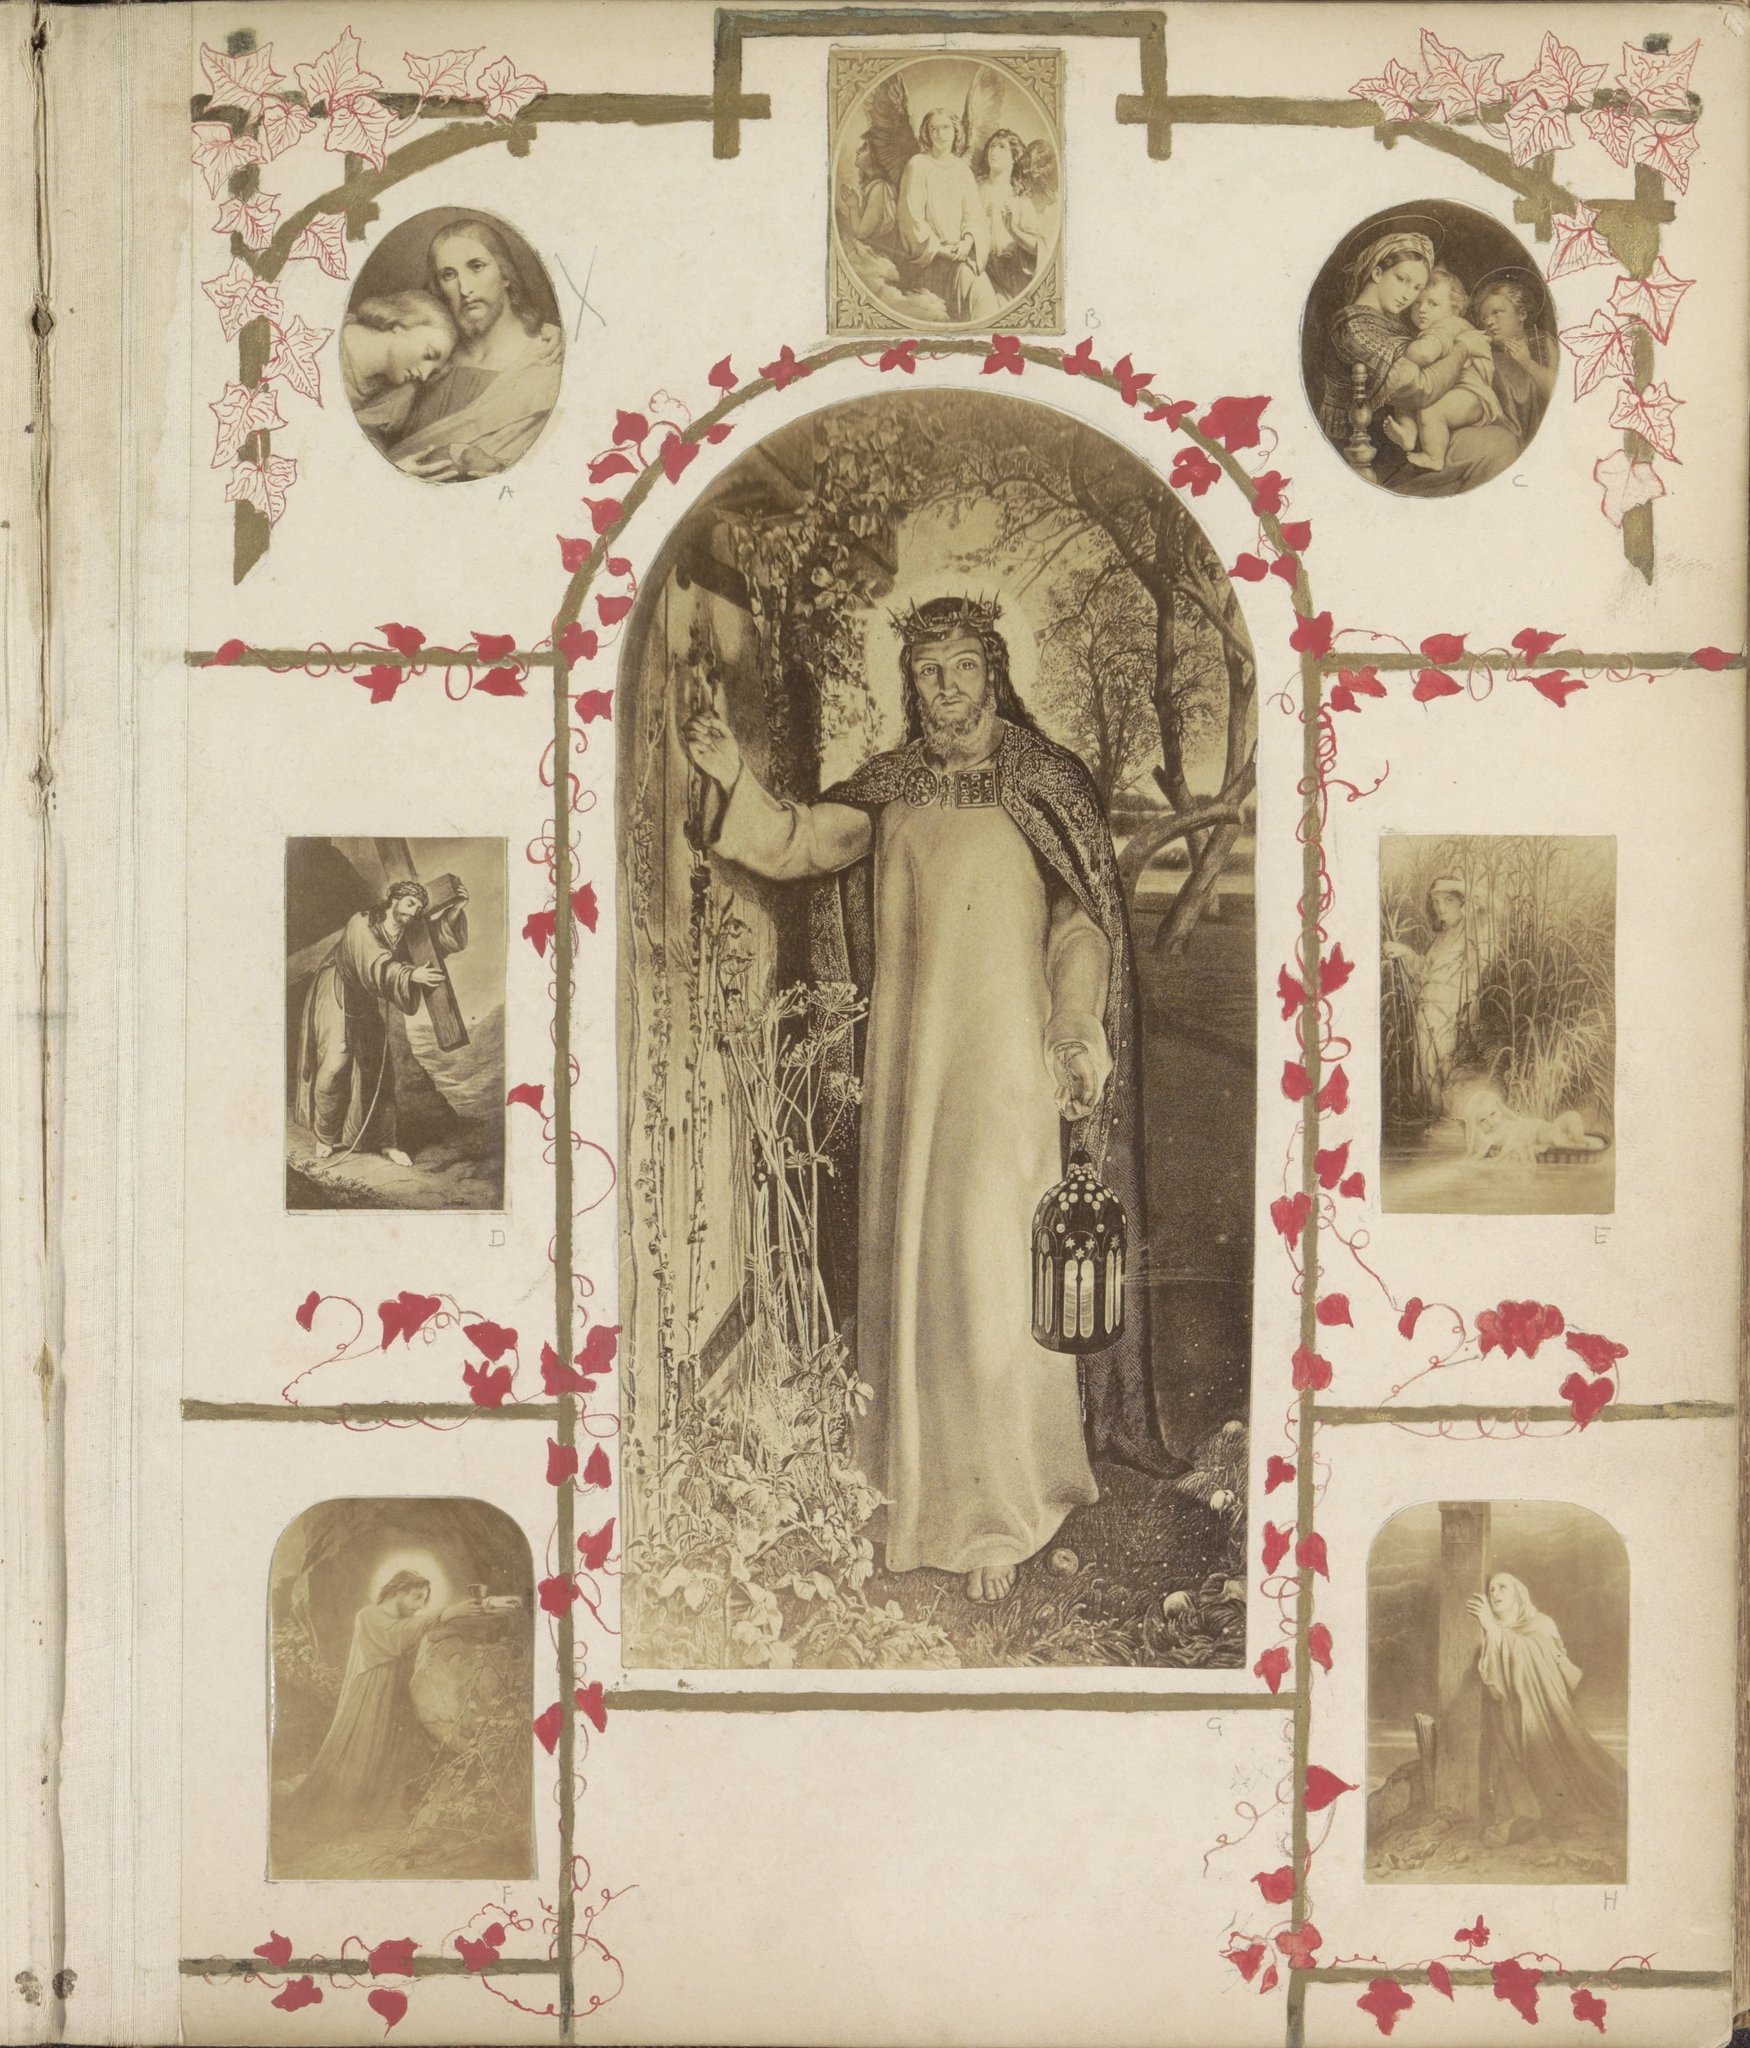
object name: photograph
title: Fotoreproductie van (vermoedelijk) een prent naar een schilderij van Rafaël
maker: Anonymous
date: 1850-1870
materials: paper, photographic support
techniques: albumen print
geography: england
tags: madonna: i.e. mary with the christ-child, john the baptist as child ~ madonna-representations (n.b. secondary notation only)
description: Onderdeel van Album met foto's van bezienswaardigheden en landschappen in Engeland en van kunst.